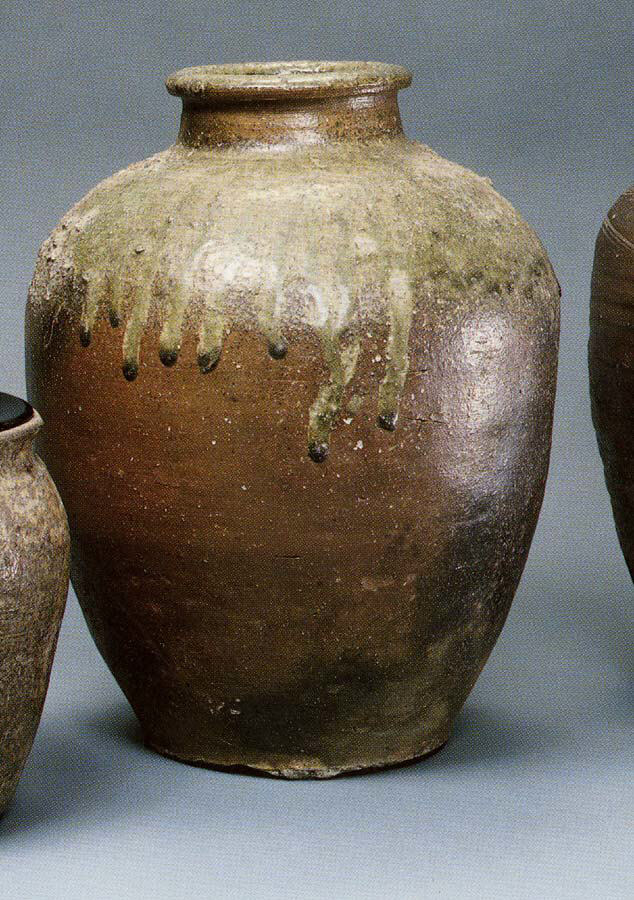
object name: storage jar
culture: japanese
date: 1500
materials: wood, glaze, stoneware